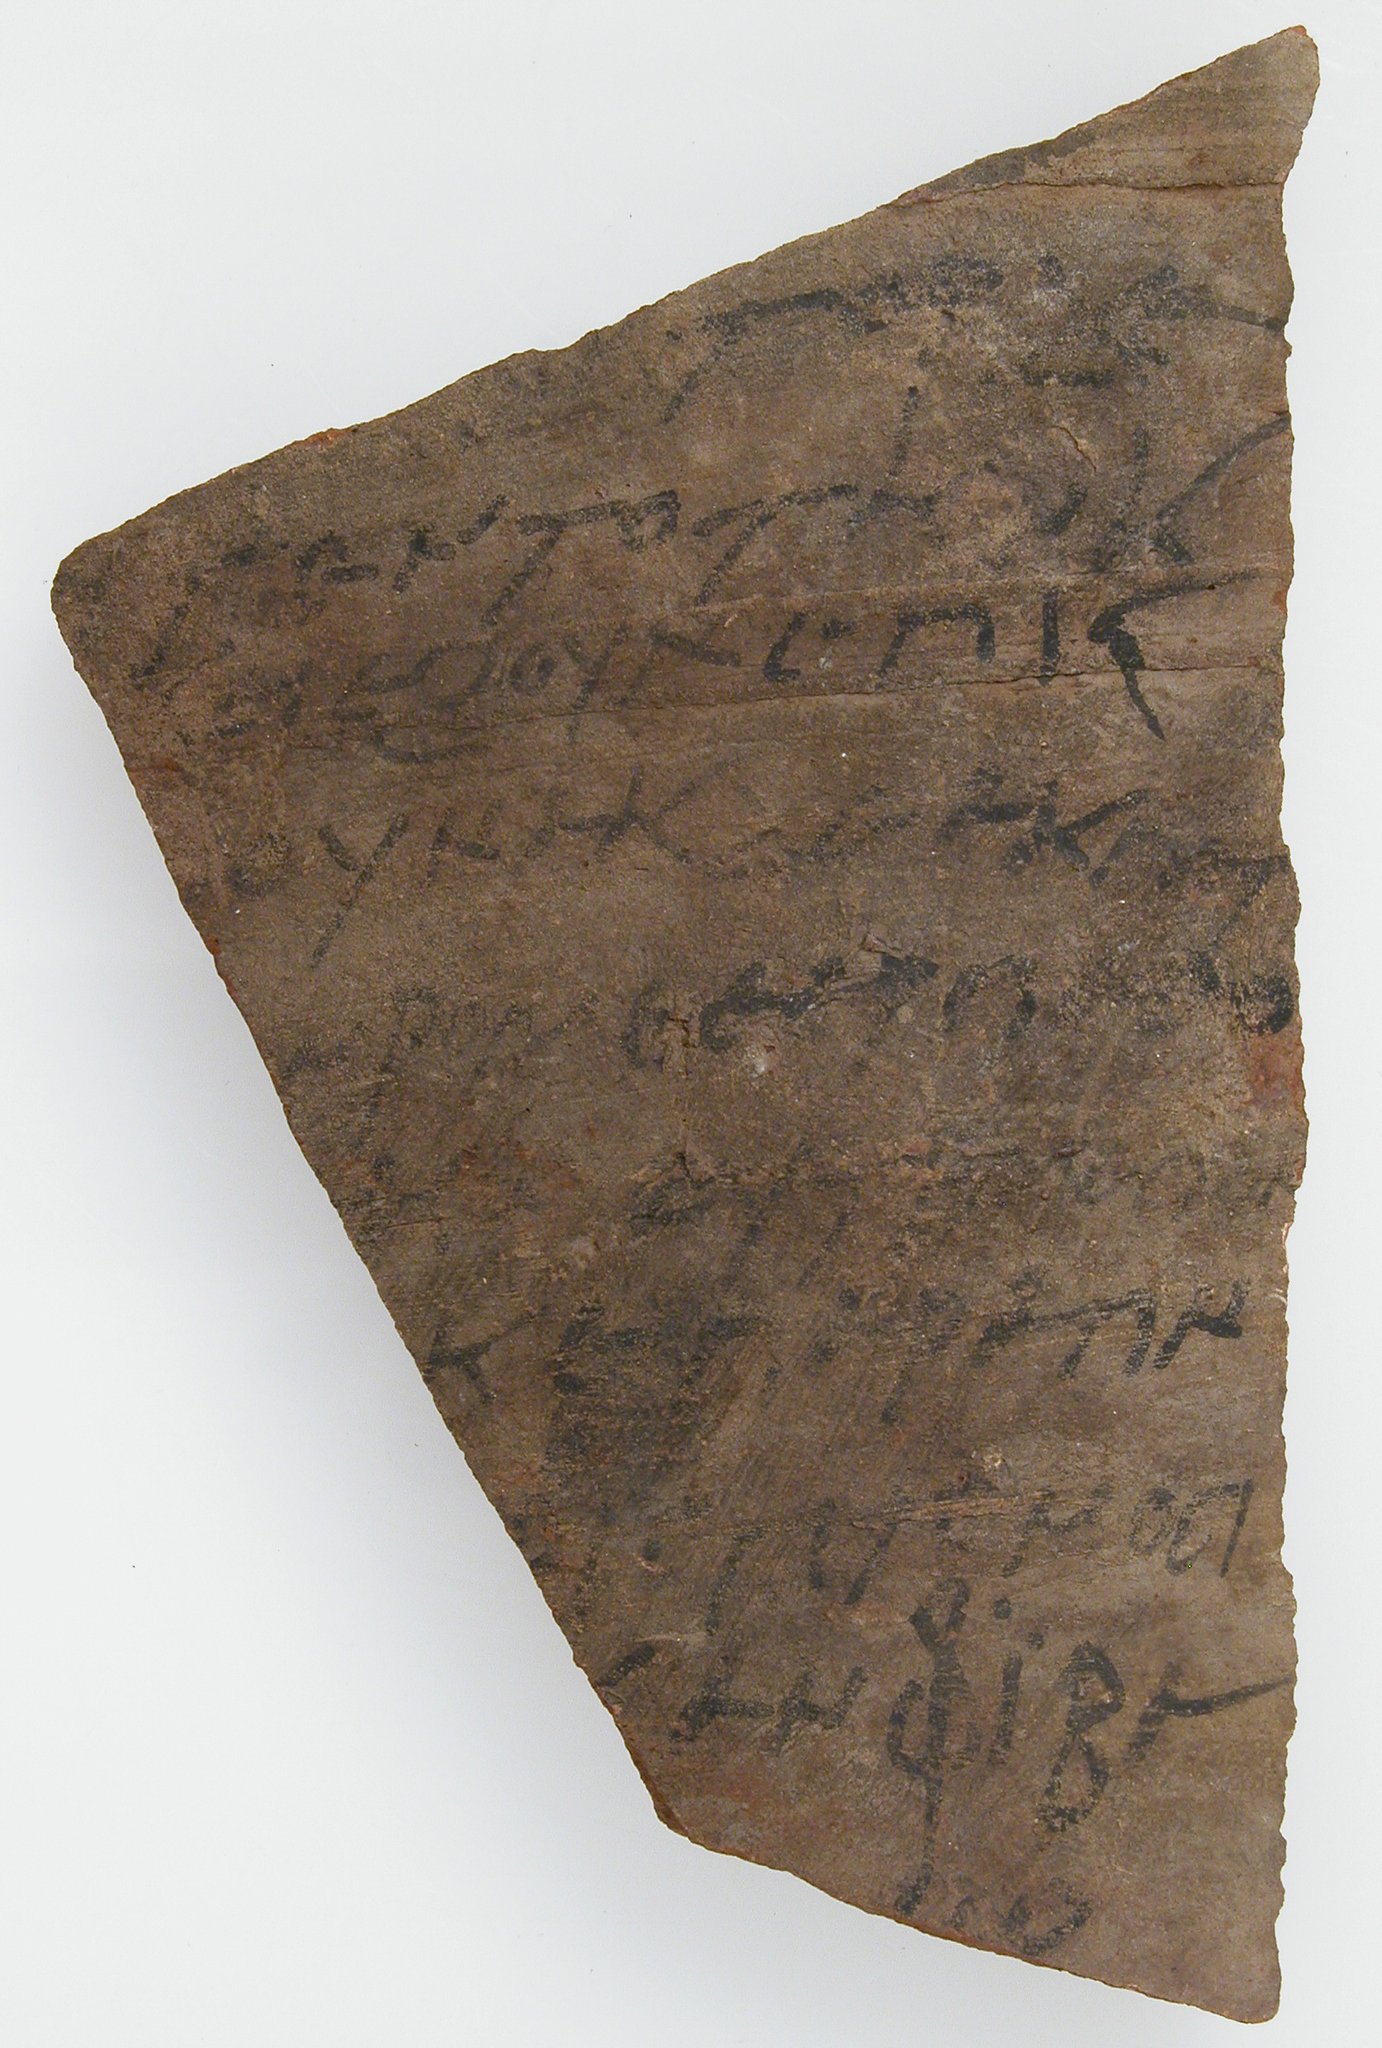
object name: ostrakon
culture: coptic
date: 600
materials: ink, pottery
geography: egypt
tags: coptic,documents